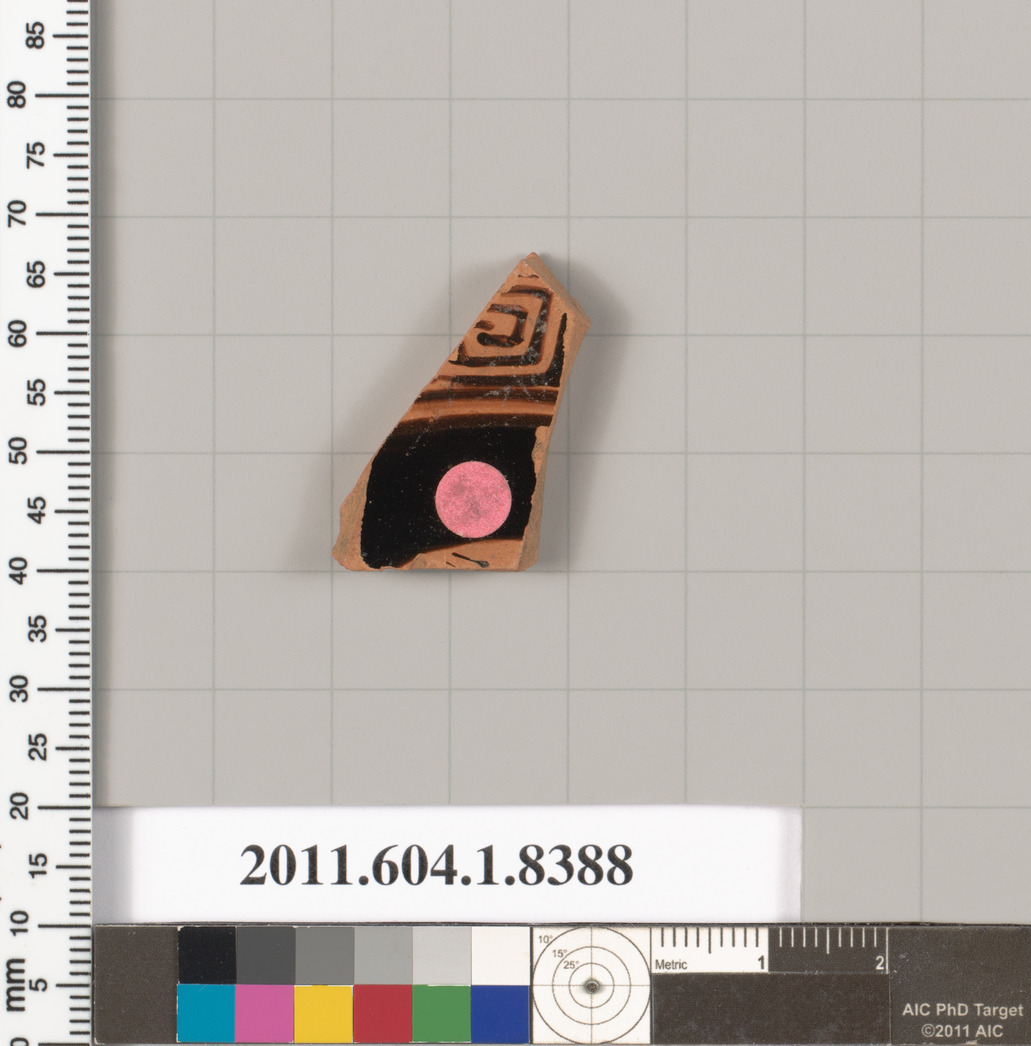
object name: kylix fragment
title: Terracotta fragment of a kylix (drinking cup)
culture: greek, attic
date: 400-351 BCE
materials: terracotta